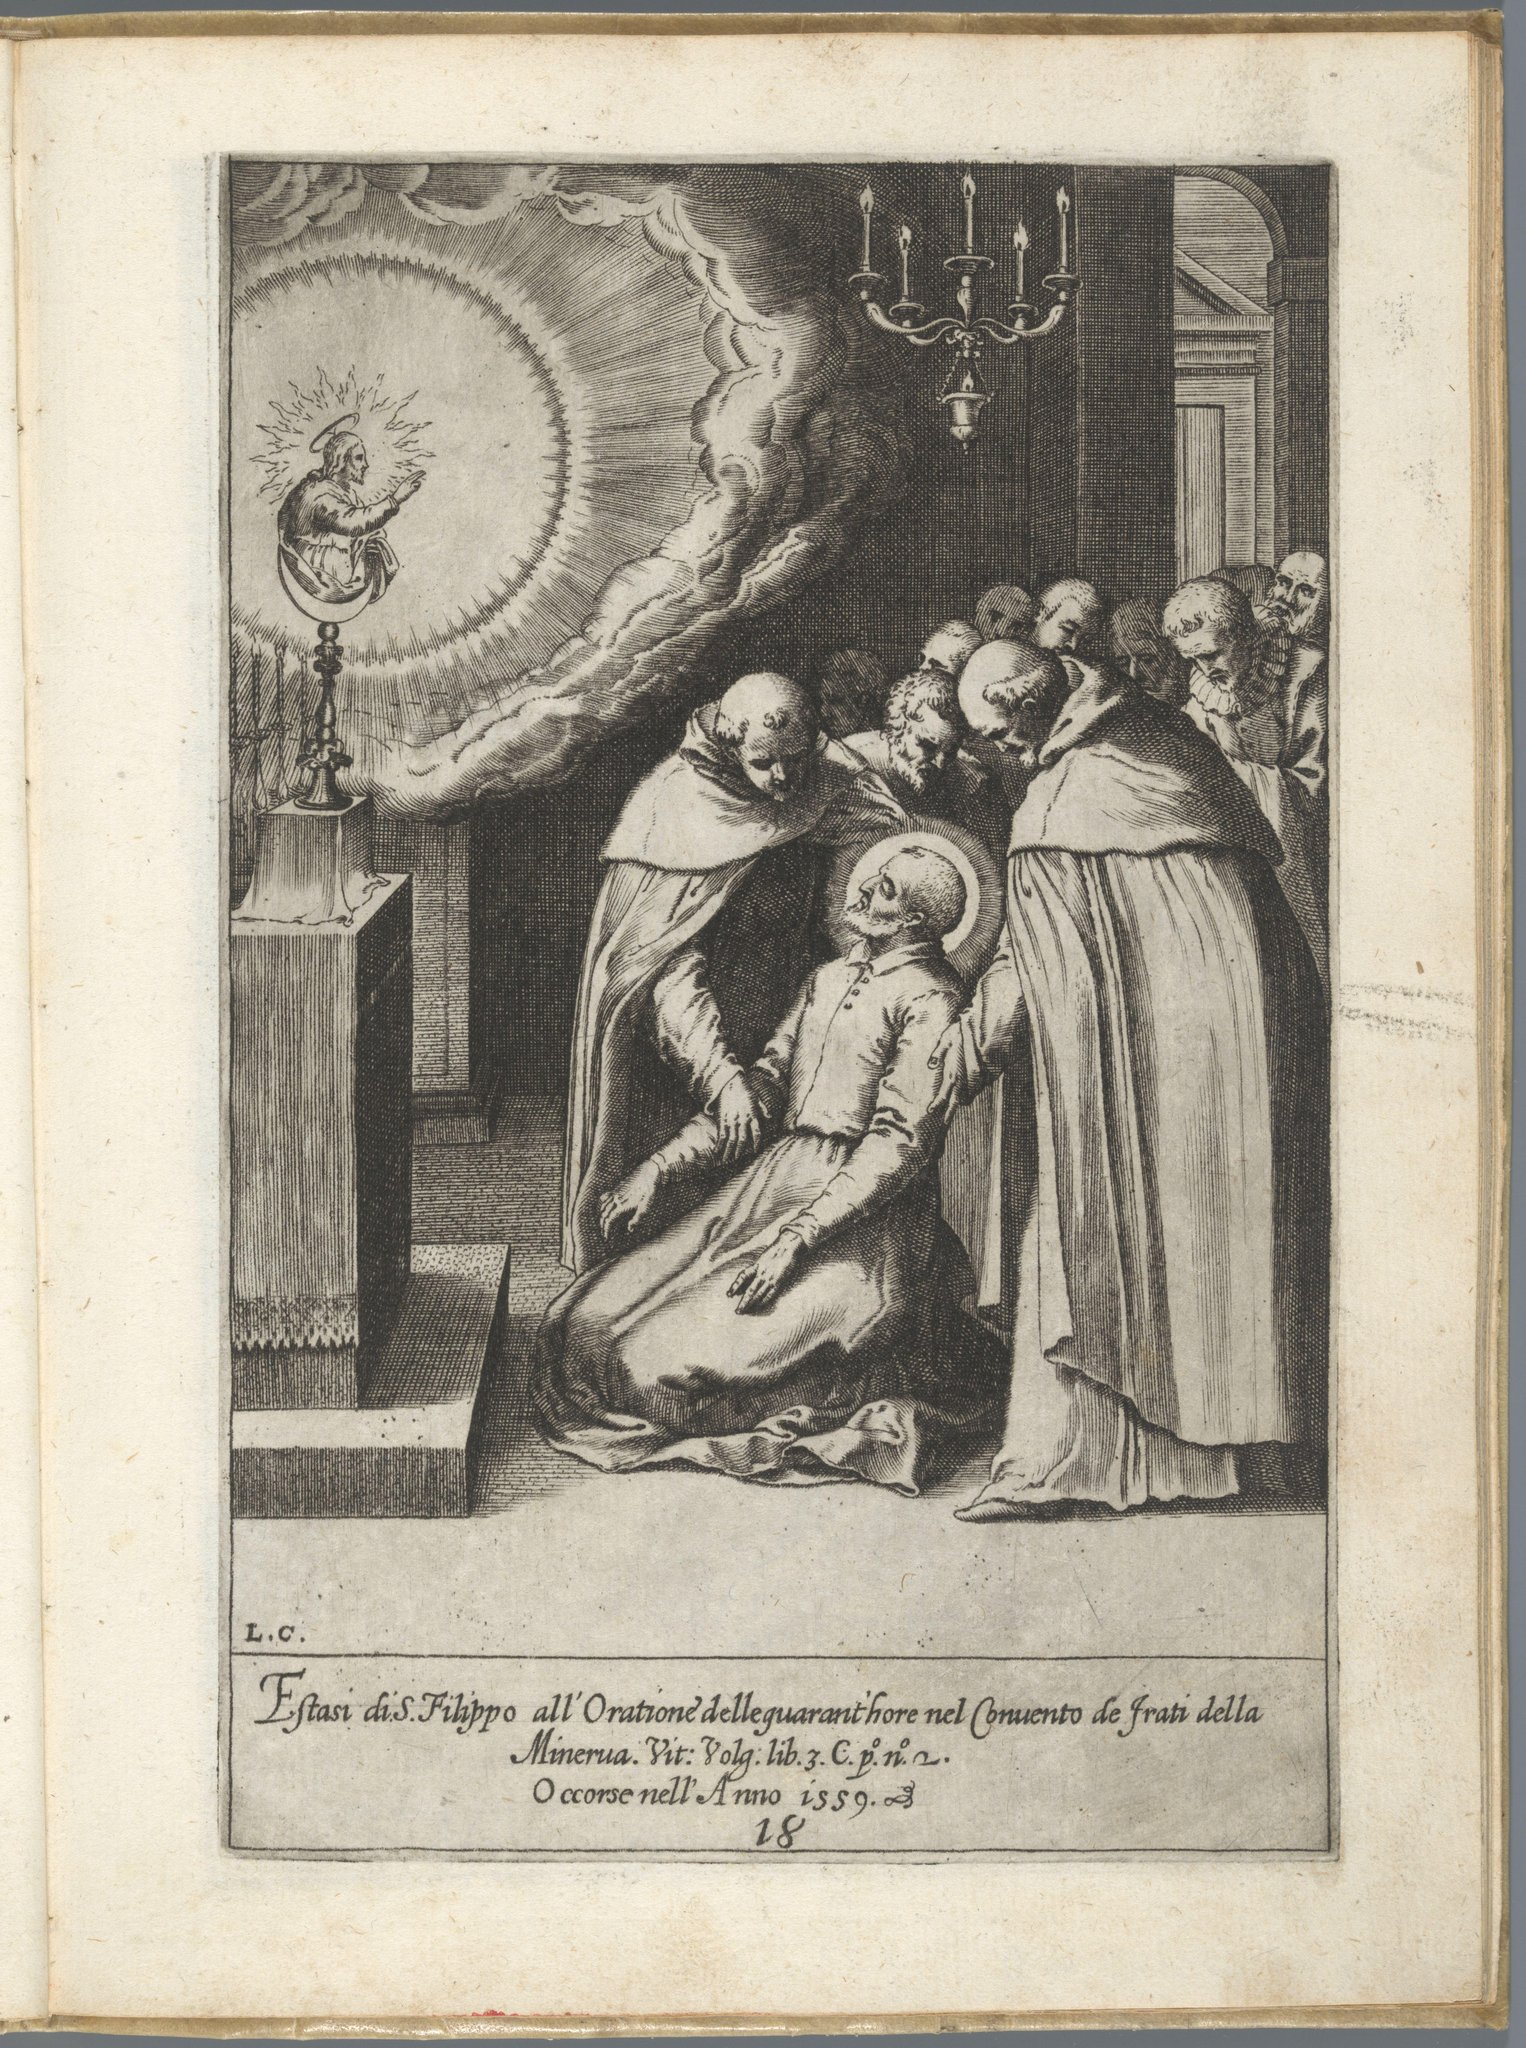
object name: print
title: Leven van de heilige Filippo Neri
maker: luca ciamberlano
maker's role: painter, print maker, publisher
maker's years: 1570-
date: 1630-1641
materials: paper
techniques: engraving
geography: rome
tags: rome, clergyman, the founder of the congregation of the oratory (oratorians) philip neri; possible attributes: lily, rosary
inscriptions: collector's mark: Lugt 2760, collector's mark: Lugt 2228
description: Filippo Neri in extase na veertig uur bidden (1559). Prent nr. 1 in een serie van 44 prenten met scènes uit het leven van de heilige Filippo Neri.